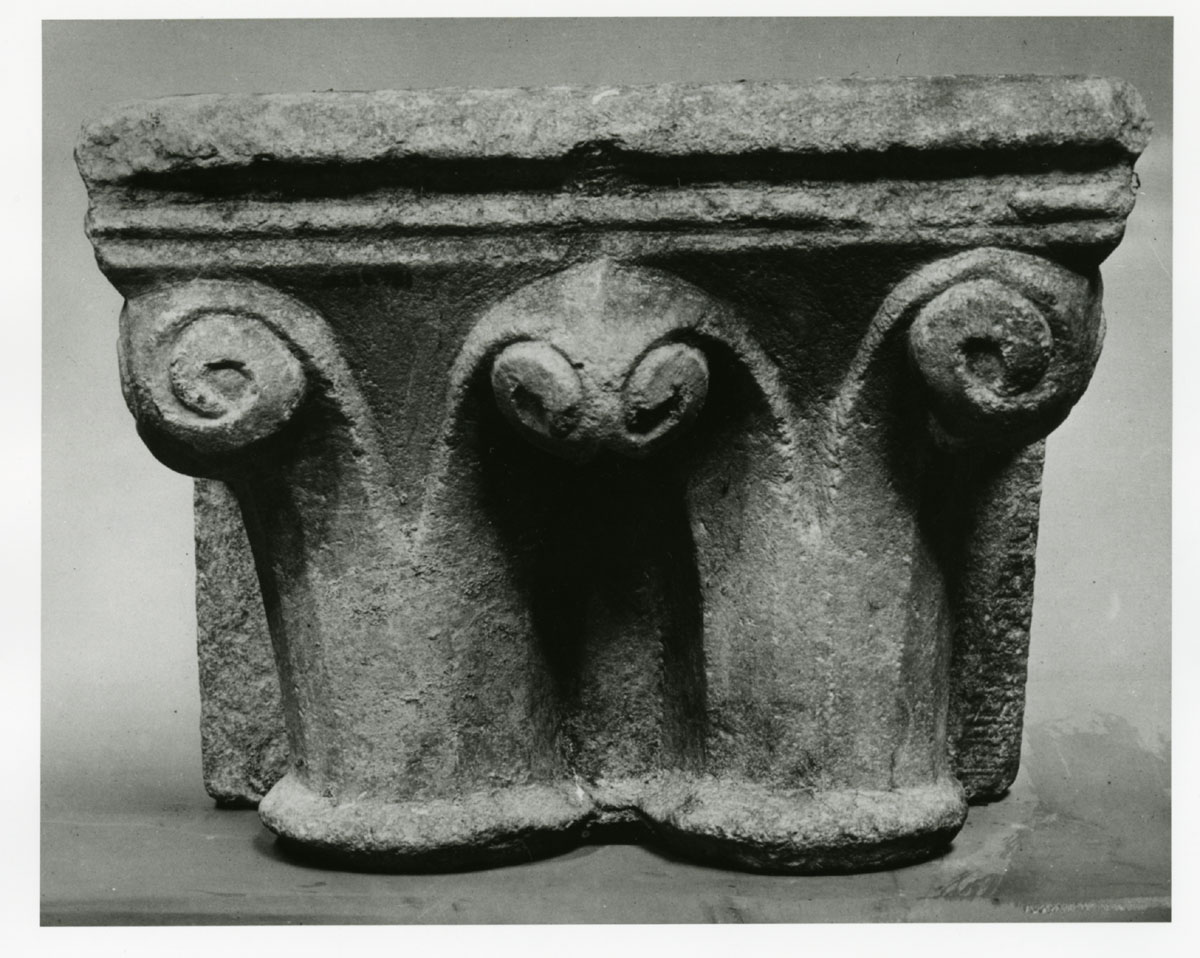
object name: capital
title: Double Capital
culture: french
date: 1267-1333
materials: marble